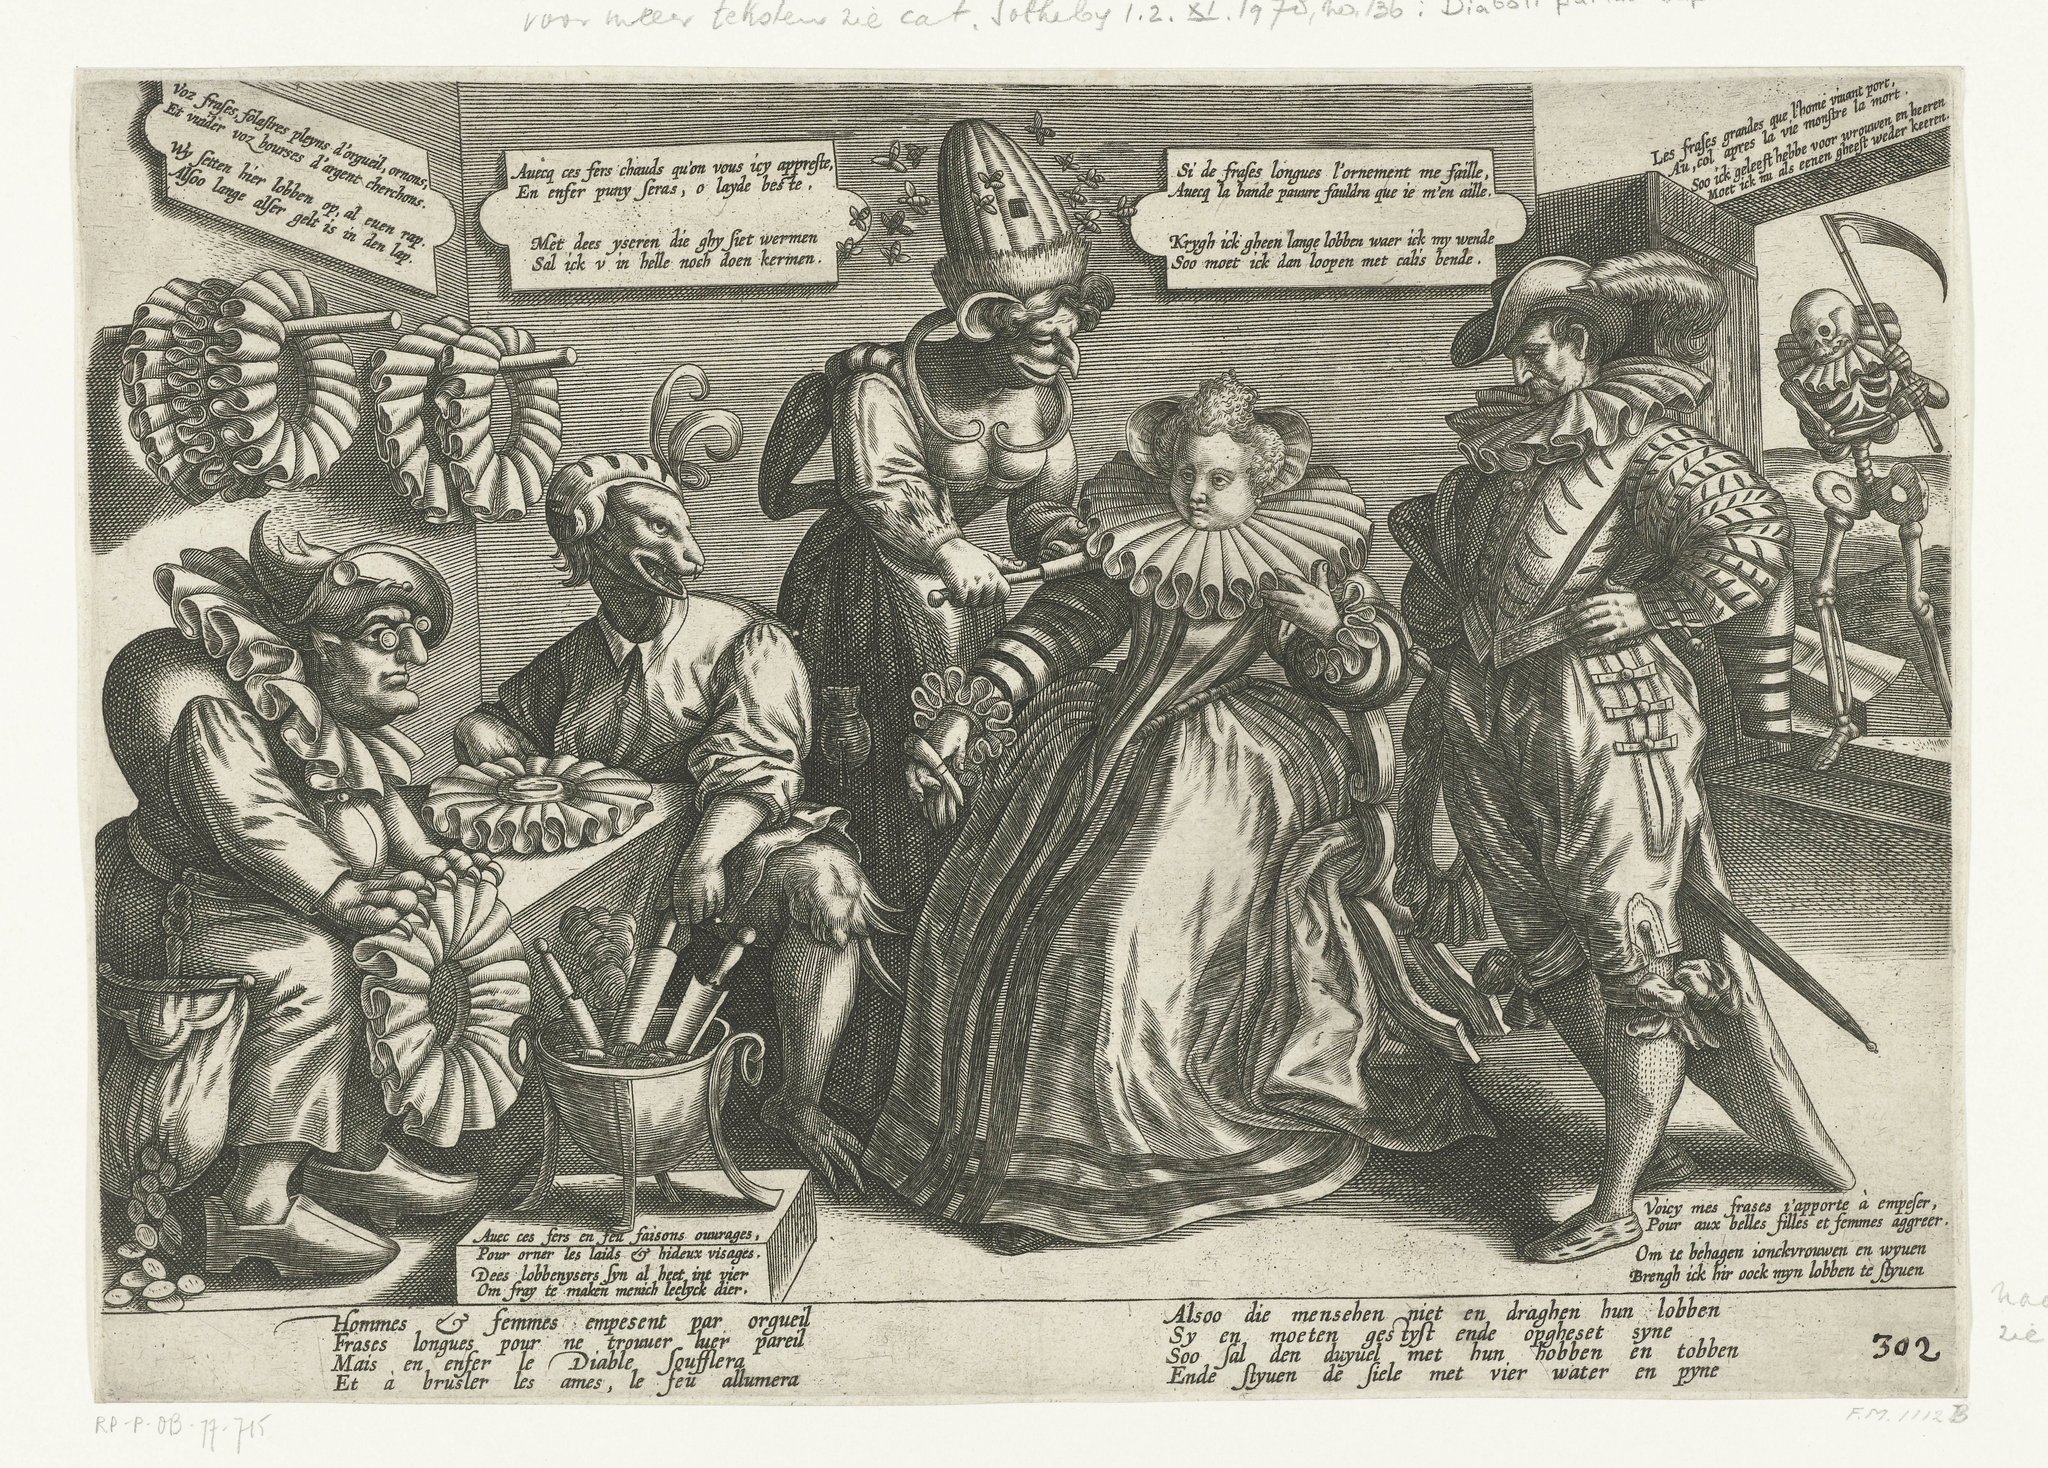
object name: print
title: Diaboli partus superbia / Hoovaardije des Duyvels broersel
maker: Anonymous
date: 1600-1624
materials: paper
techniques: engraving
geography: low countries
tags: neck-gear ~ clothing (with name) (+ men's clothes), neck-gear ~ clothing (with name) (+ stadia of production ~ home making of clothes), scenes symbolizing 'vanitas', pride; 'superbia' (ripa) ~ personification of one of the seven deadly sins, neck-gear ~ clothing (with name) (+ women's clothes), clothes, costume (+ men's clothes), bee-hive, human-shaped devil, death conquering life or the living, low countries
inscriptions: caption: ‘Also die mensehen [menschen] niet en draghen hun lobben / sy en moeten gestyft ende opgheset syne / Soo sal den duyvel met hun hobben en tobben / ende styven de siele met vier water en pyne’, caption: ‘Hommes & femmes empesent par orgueil...le feu allumera’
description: De trots van de vrouw: spotprent op de 'plooikraag', ca. 1600. In een vertrek zit een vrouw op een stoel, gekleed volgens de mode van ca. 1600-1620. De brede geplooide kraag wordt gesteven door een duivelse figuur met een bijenkorf op het hoofd. Links in het vertrek twee gedrochten die bezig zijn met het stijven van kragen die ze aan stokken aan de muur hangen. Rechts een elegant gekleed heer. In de deuropening de dood in de gedaante van een skelet met zeis. Met verklarende teksten in de voorstelling en met onderschrift van 2 keer 4 regels in het Frans en Nederlands.